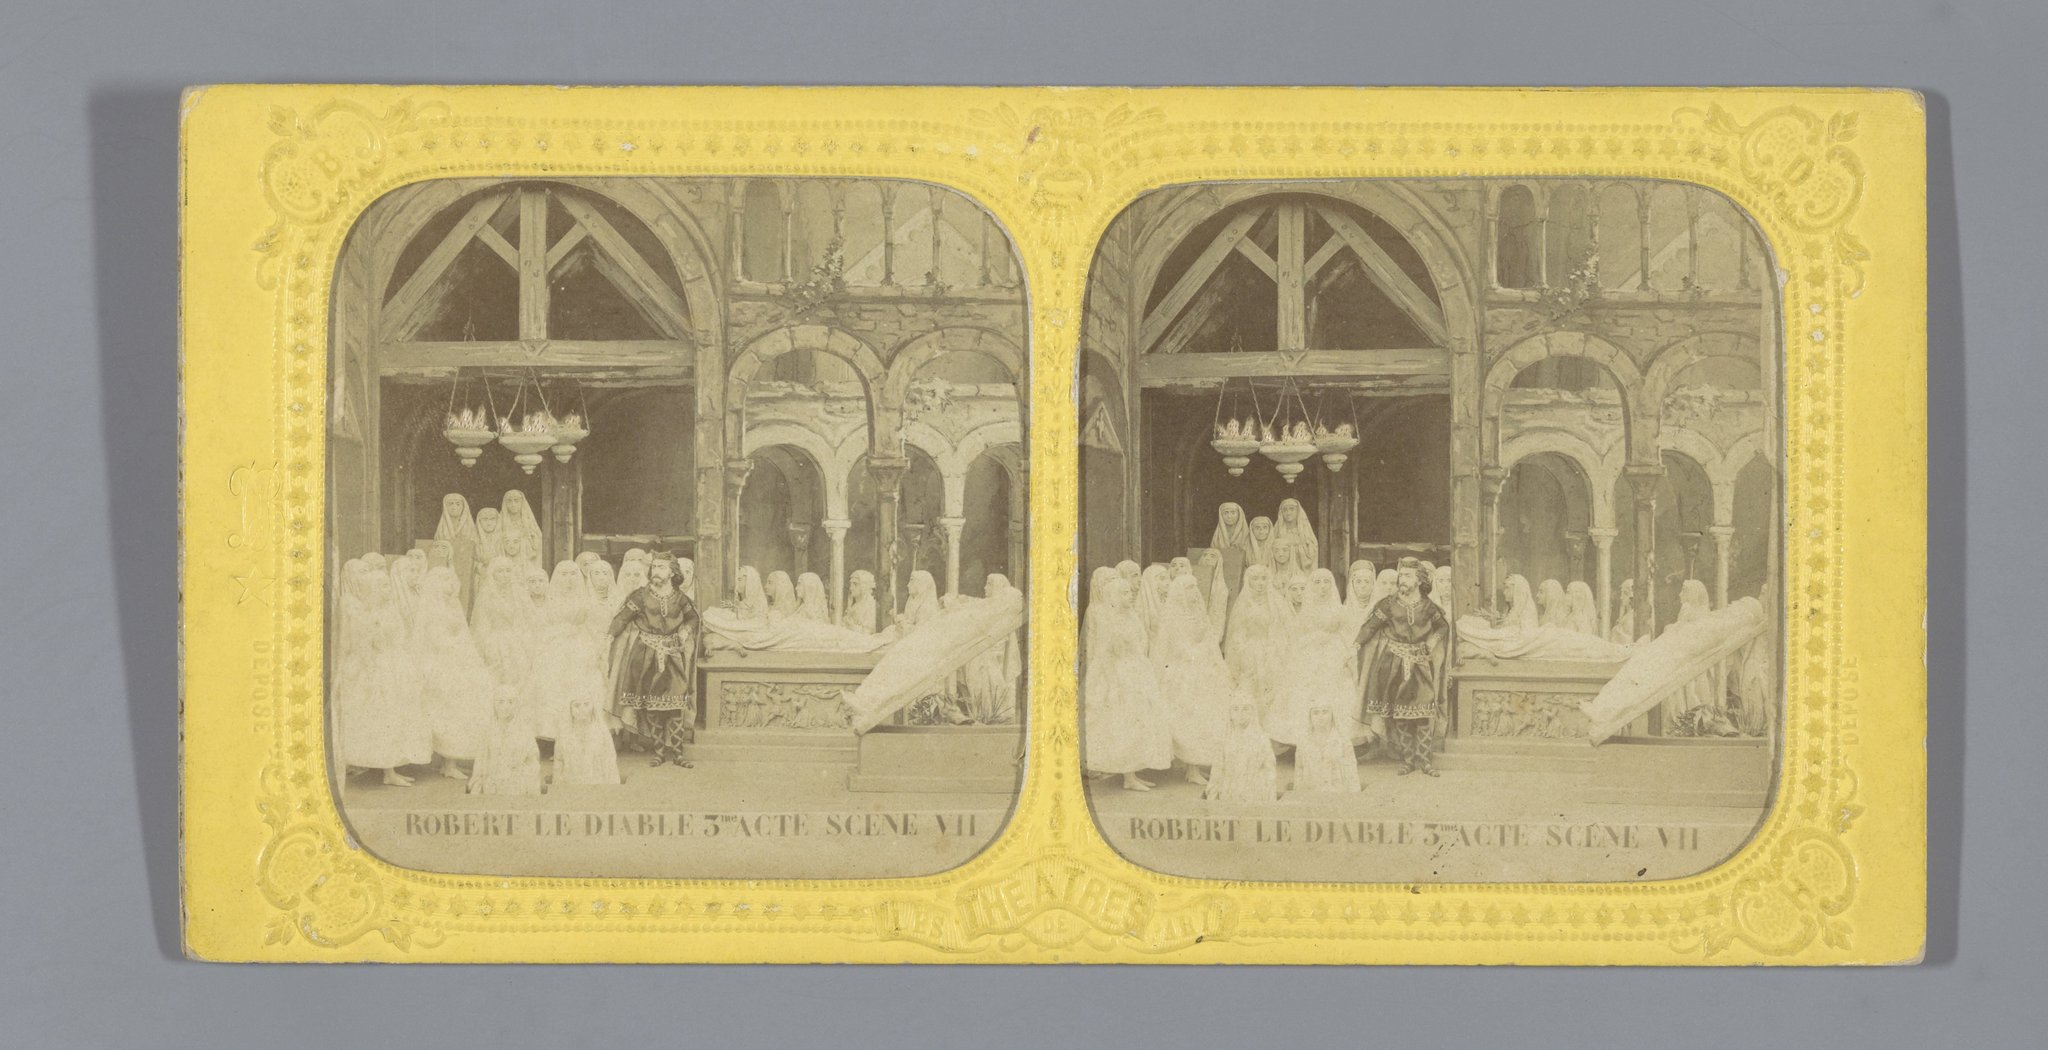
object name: tissue stereograph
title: Robert le Diable, 3me acte, scene VII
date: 1873-1874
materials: cardboard, paper, photographic support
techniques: hand coloring, perforating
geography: paris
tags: opera, paris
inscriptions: inscription: ‘DEPOSE’, name: ‘J. J. Henny’, inscription: ‘Le dépôt de cette publication ayant été fait en France selo la loi, et à/ l'etranger conformémt aux conventions internationnales, toute reproduc-/ tion en est rigoureusemt interdite, et les épreuves non revêtues de notre/ marque de fabrique seront considérées comme contrefacon. - B et D éditrs.’